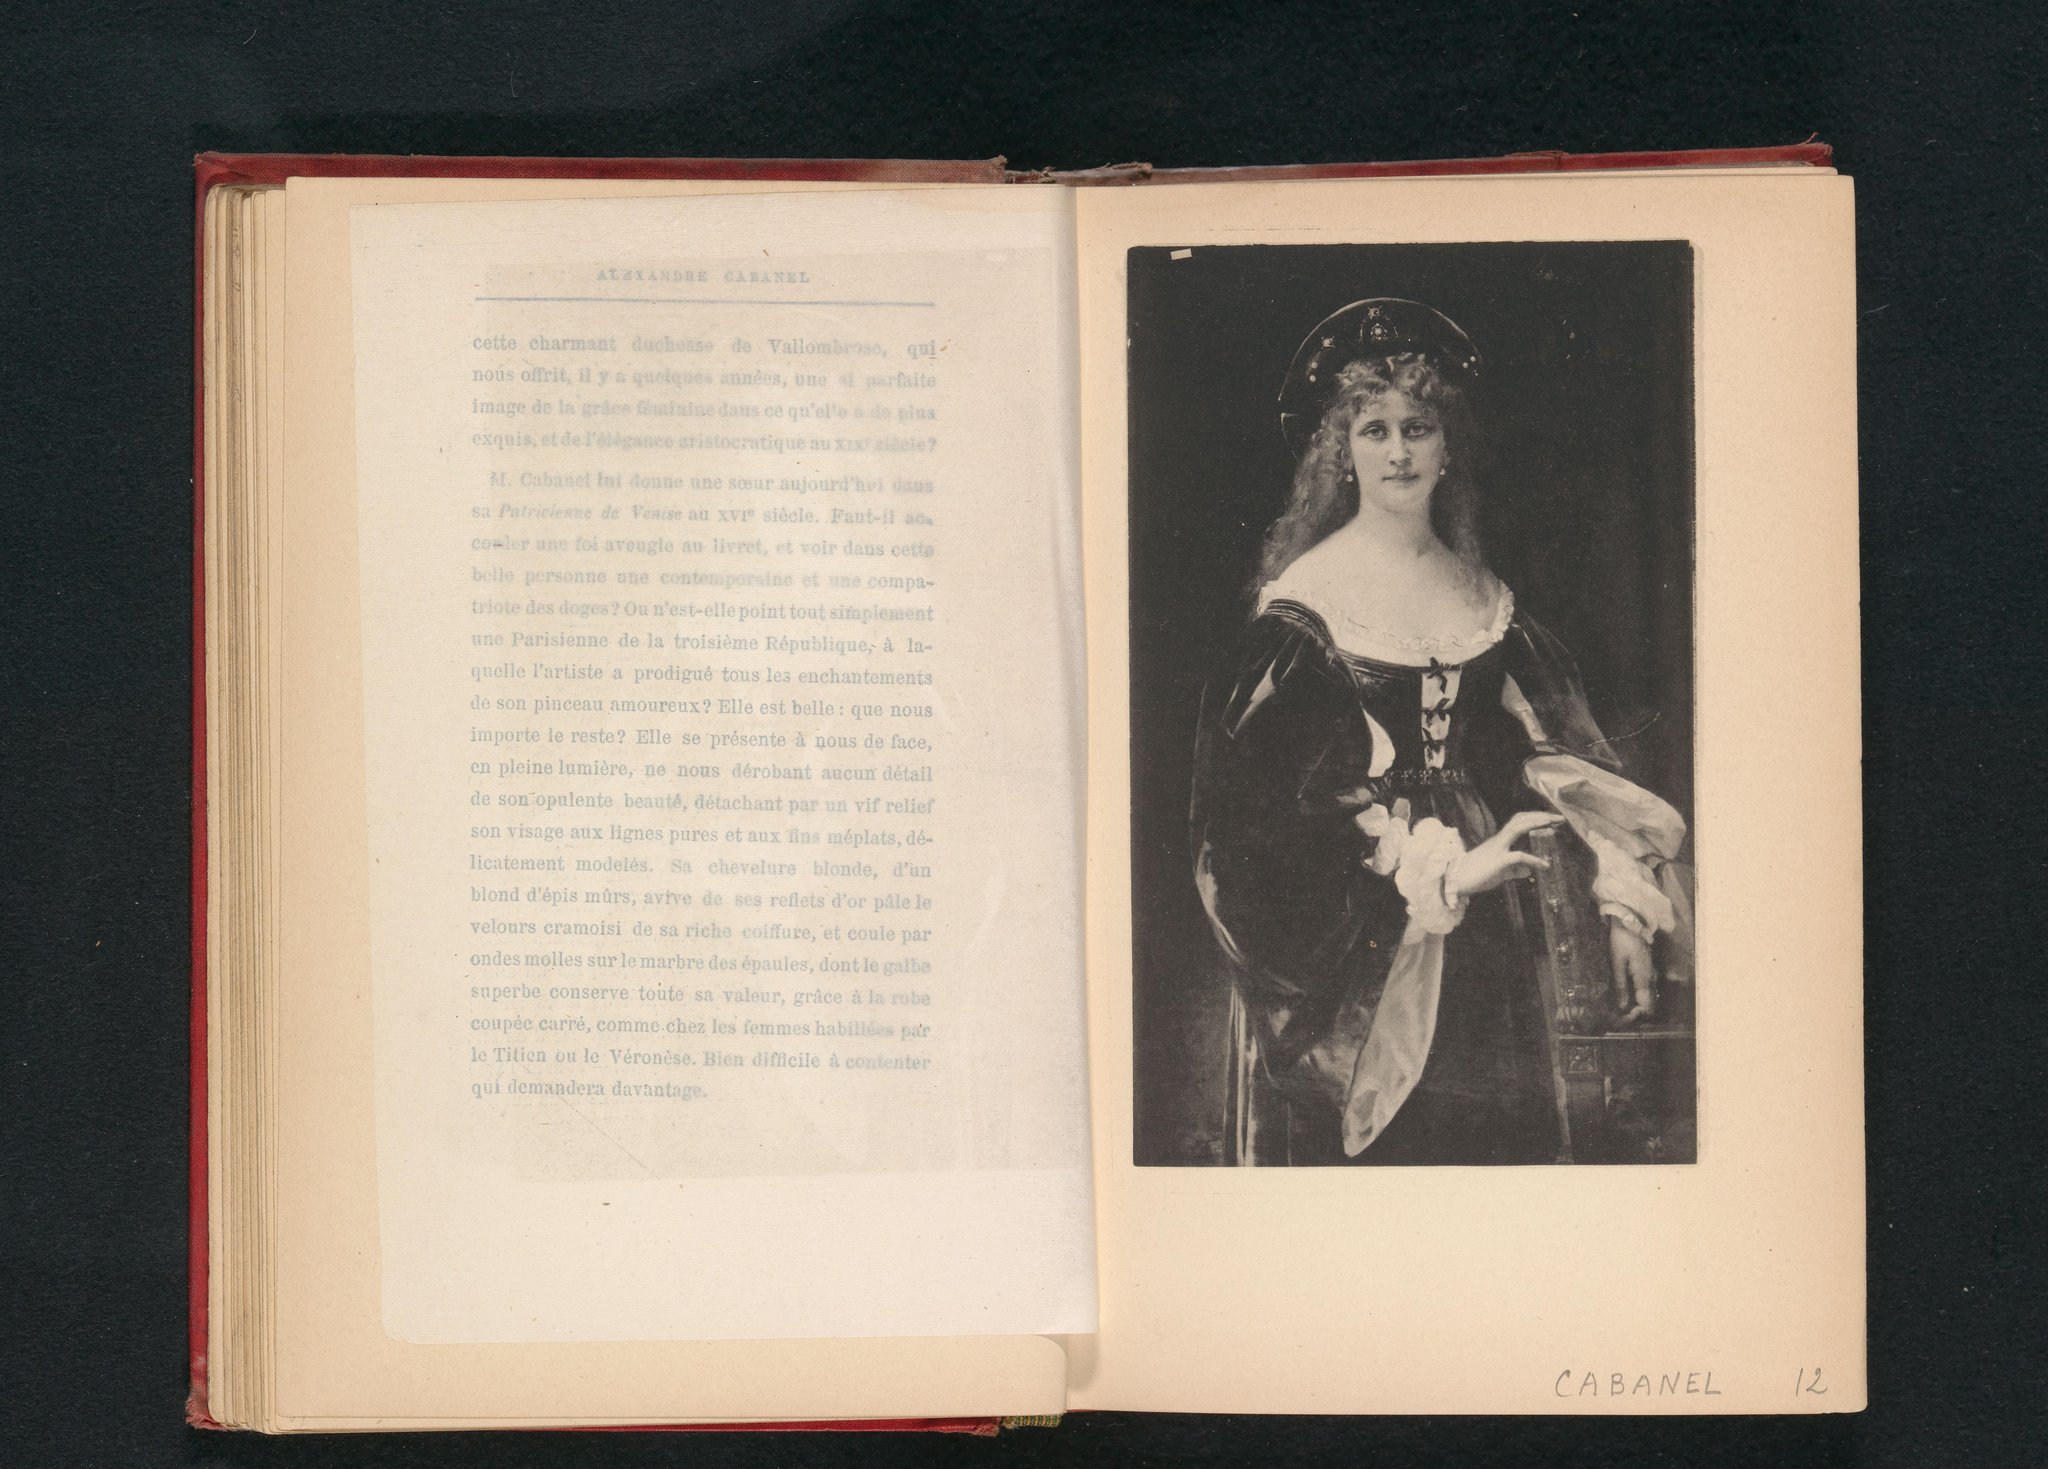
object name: page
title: Fotoreproductie van het schilderij Patricienne de Venise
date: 1872-1882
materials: paper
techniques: photograph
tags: historical persons not known by name - bb - woman, chair